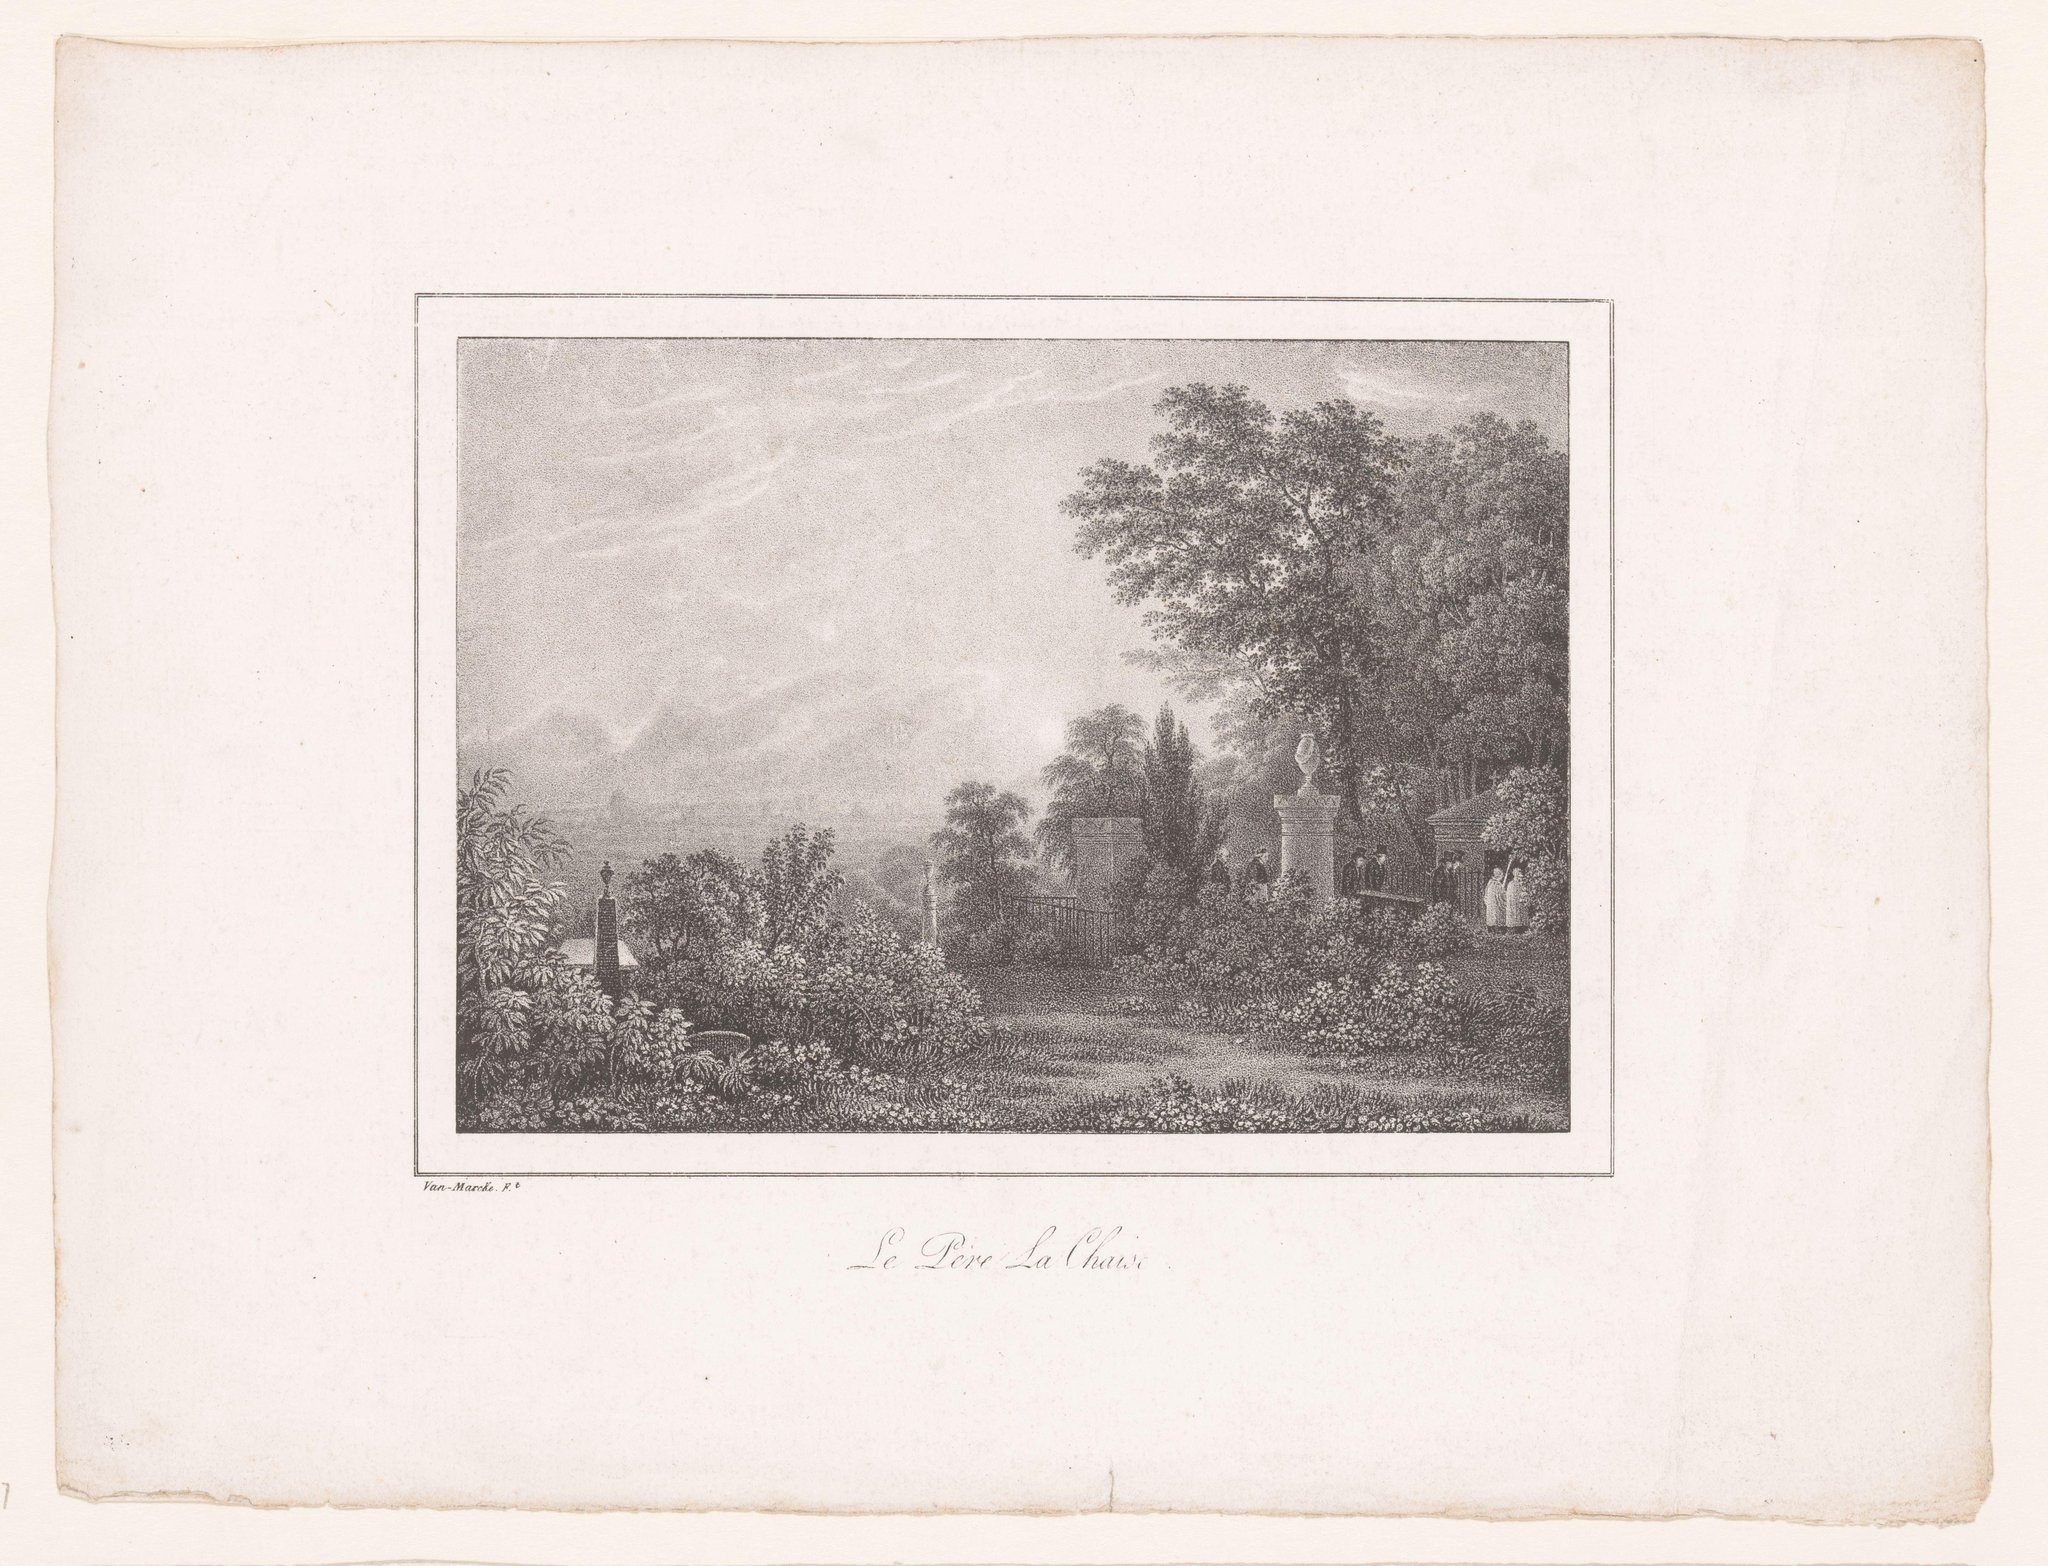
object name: print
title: Le Père La Chaise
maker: jean baptiste van marcke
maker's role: print maker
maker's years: 1798-1849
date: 1808-1849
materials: paper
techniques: lithograph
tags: cemetery, park-like burying ground, paris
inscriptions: collector's mark: Lugt 2228